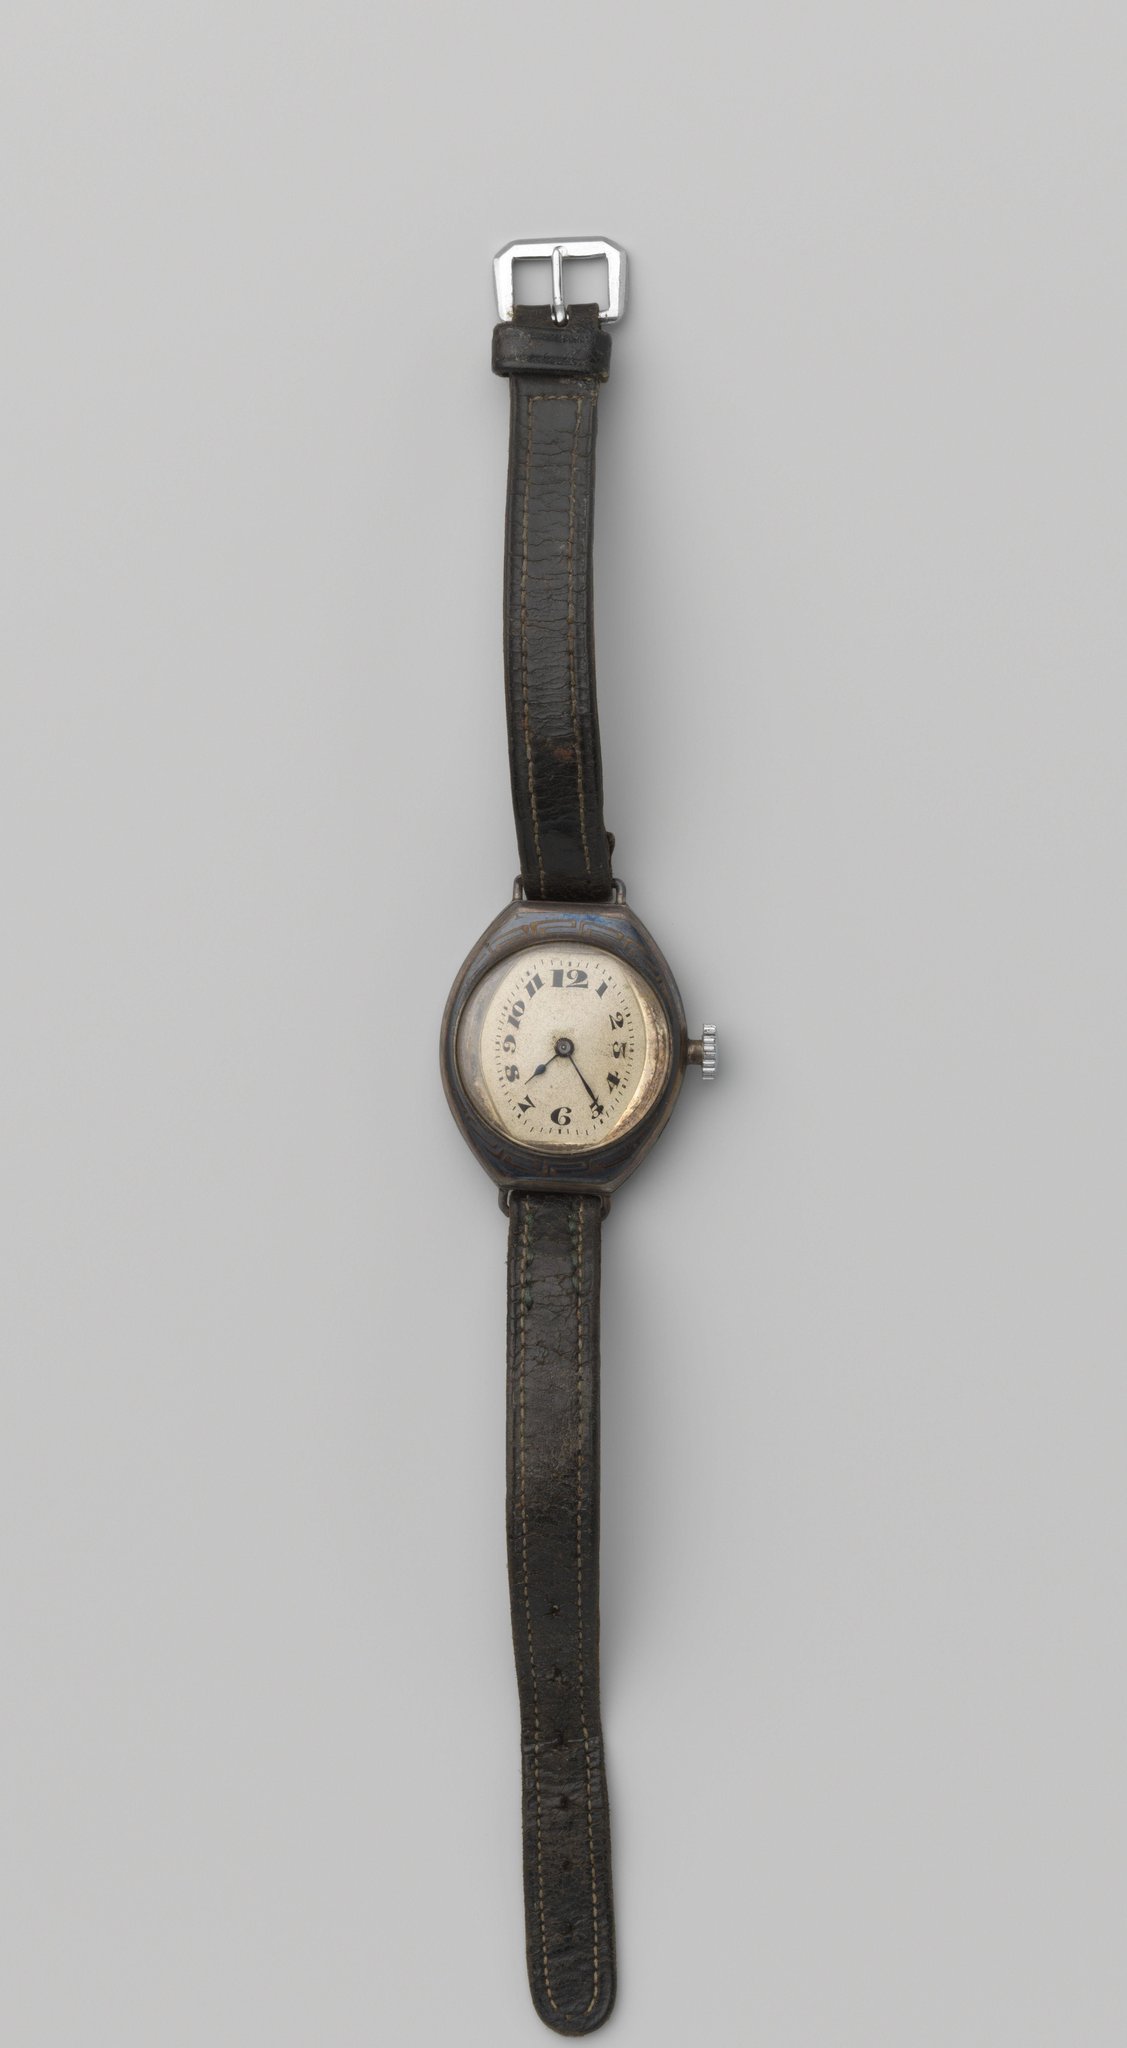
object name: wrist watch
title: Horloge van zilver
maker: Anonymous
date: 1925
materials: leather, niello, silver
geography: marken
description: Armbandhorloge van zilver, met niello motieven. Staand ovaal model, afgeplat bij de oogjes. Niello-werk van hoelige meanders, breed in onder- en bovenrand, smaller wordend naar het midden der zijden. Smal leren armbandje, gevoerde riempjes met gespje van ondedel metaal.